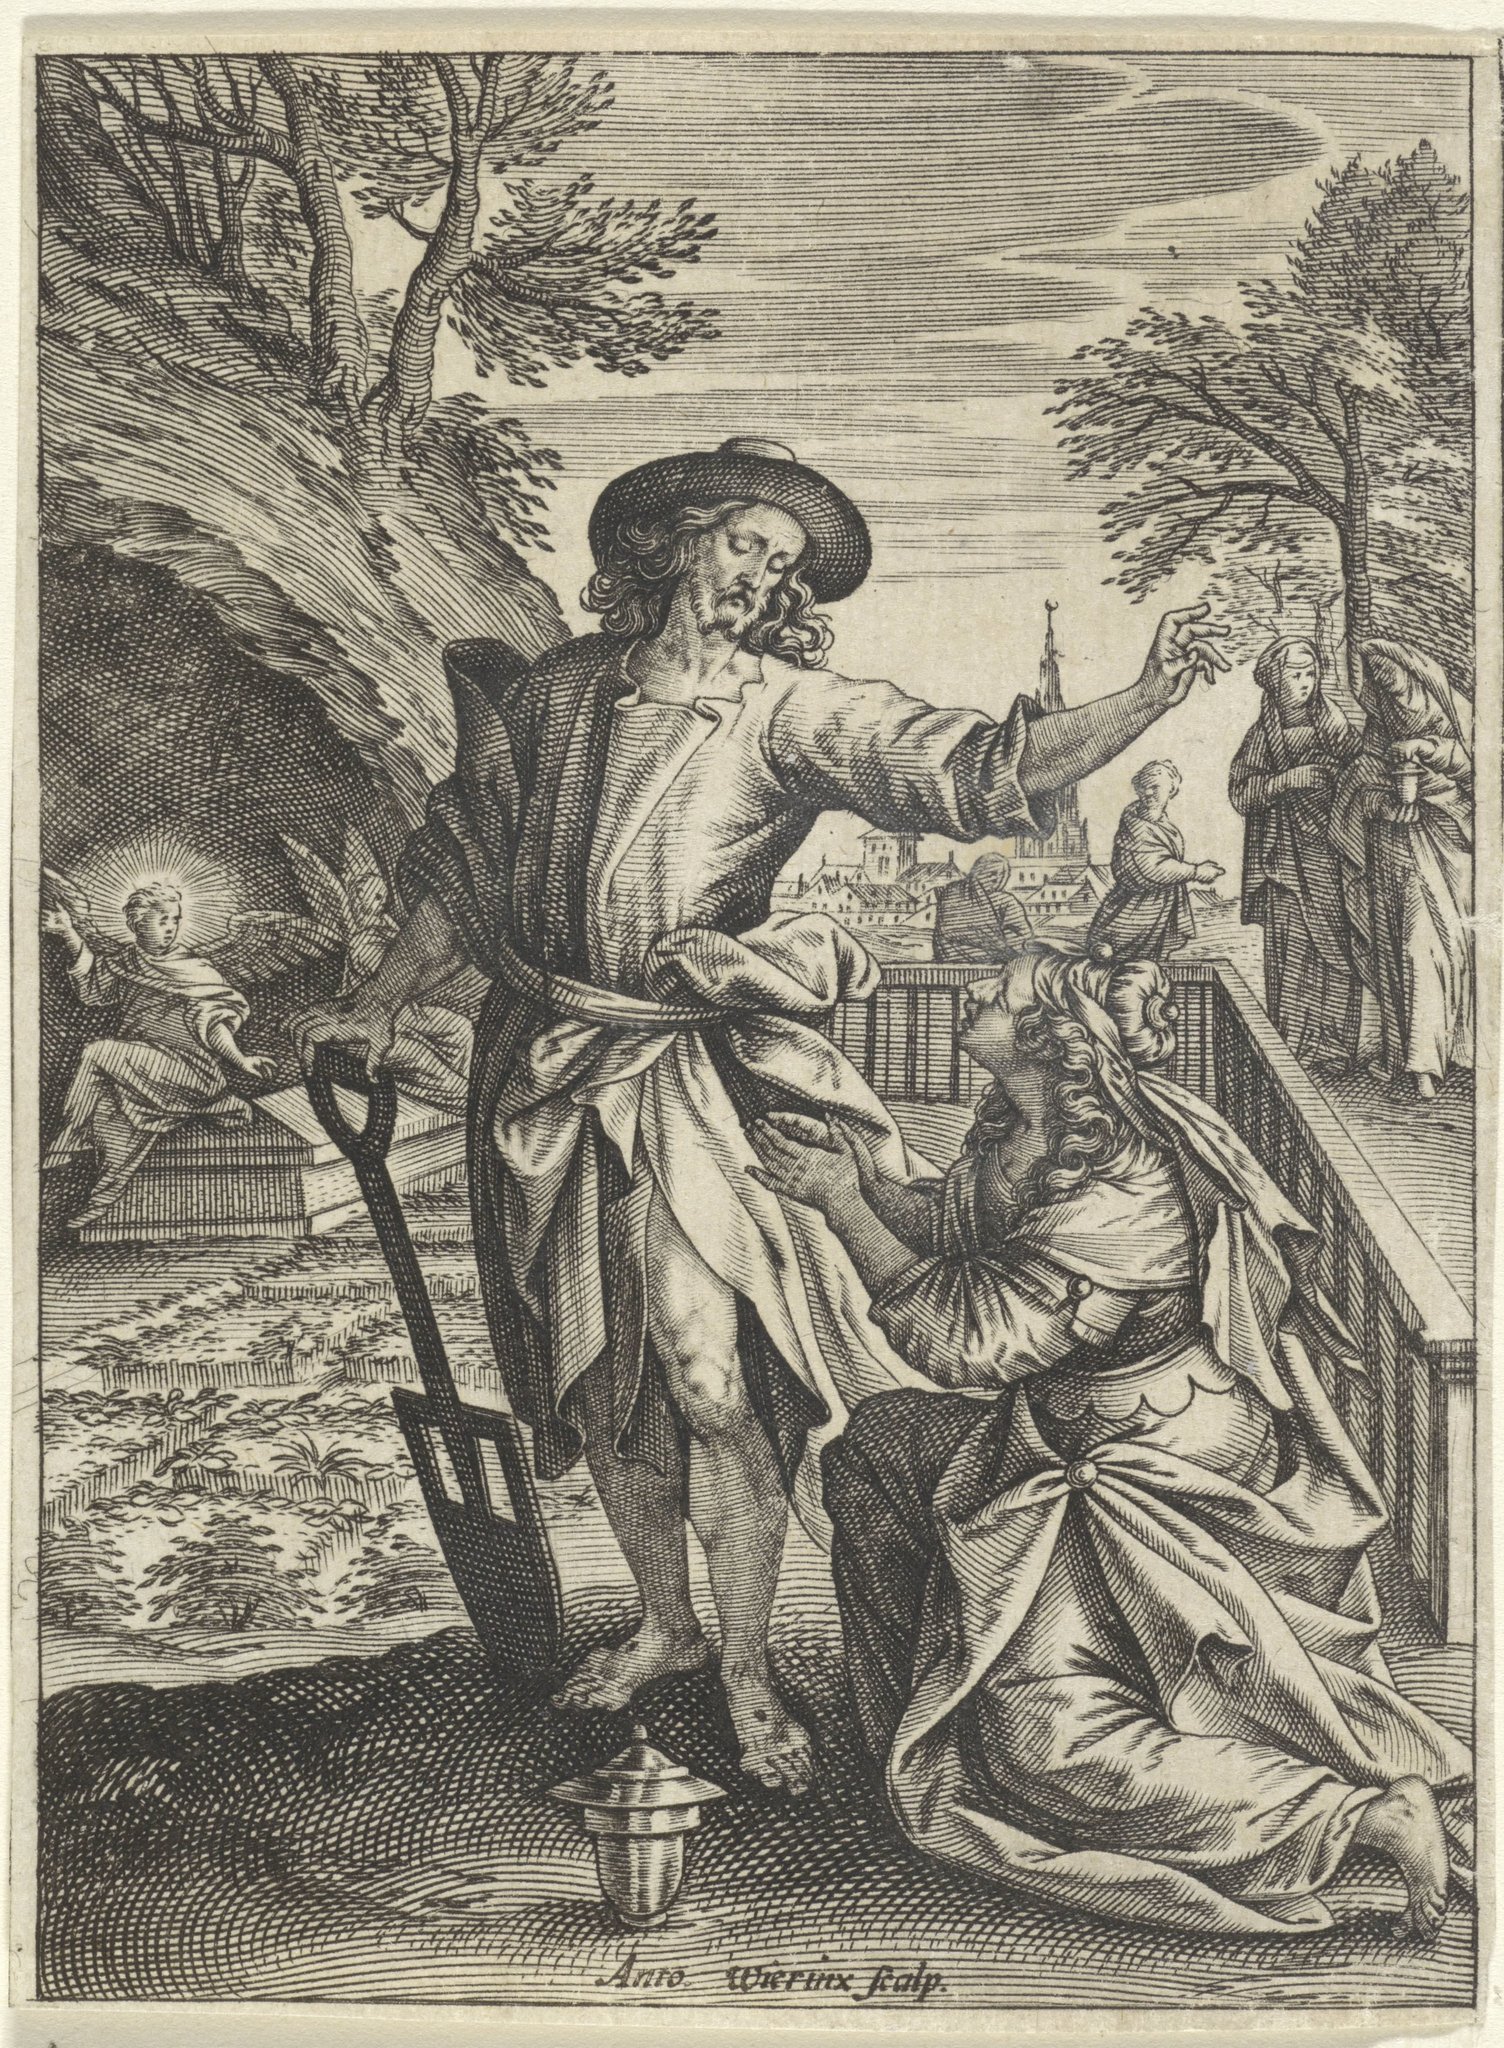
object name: print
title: Passie van Christus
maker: antonie wierix (ii)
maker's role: draughtsman, print maker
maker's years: 1555-1604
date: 1582-1586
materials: paper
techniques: engraving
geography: antwerp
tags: the holy women (the three maries) on their way to or at the tomb, to anoint christ's body, mary magdalene kneeling before christ, who is usually represented as a gardener with a hoe and/or a spade; 'noli me tangere'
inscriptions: collector's mark: Lugt 2542, collector's mark: Lugt 2228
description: Na de Opstandig verschijnt Christus als tuinman aan Maria Magdalena. Zij zit voor Christus geknield in een tuin. Op de achtergrond de drie Maria's met hun zalfpot op weg naar het graf. Bij het lege graf zit een engel.